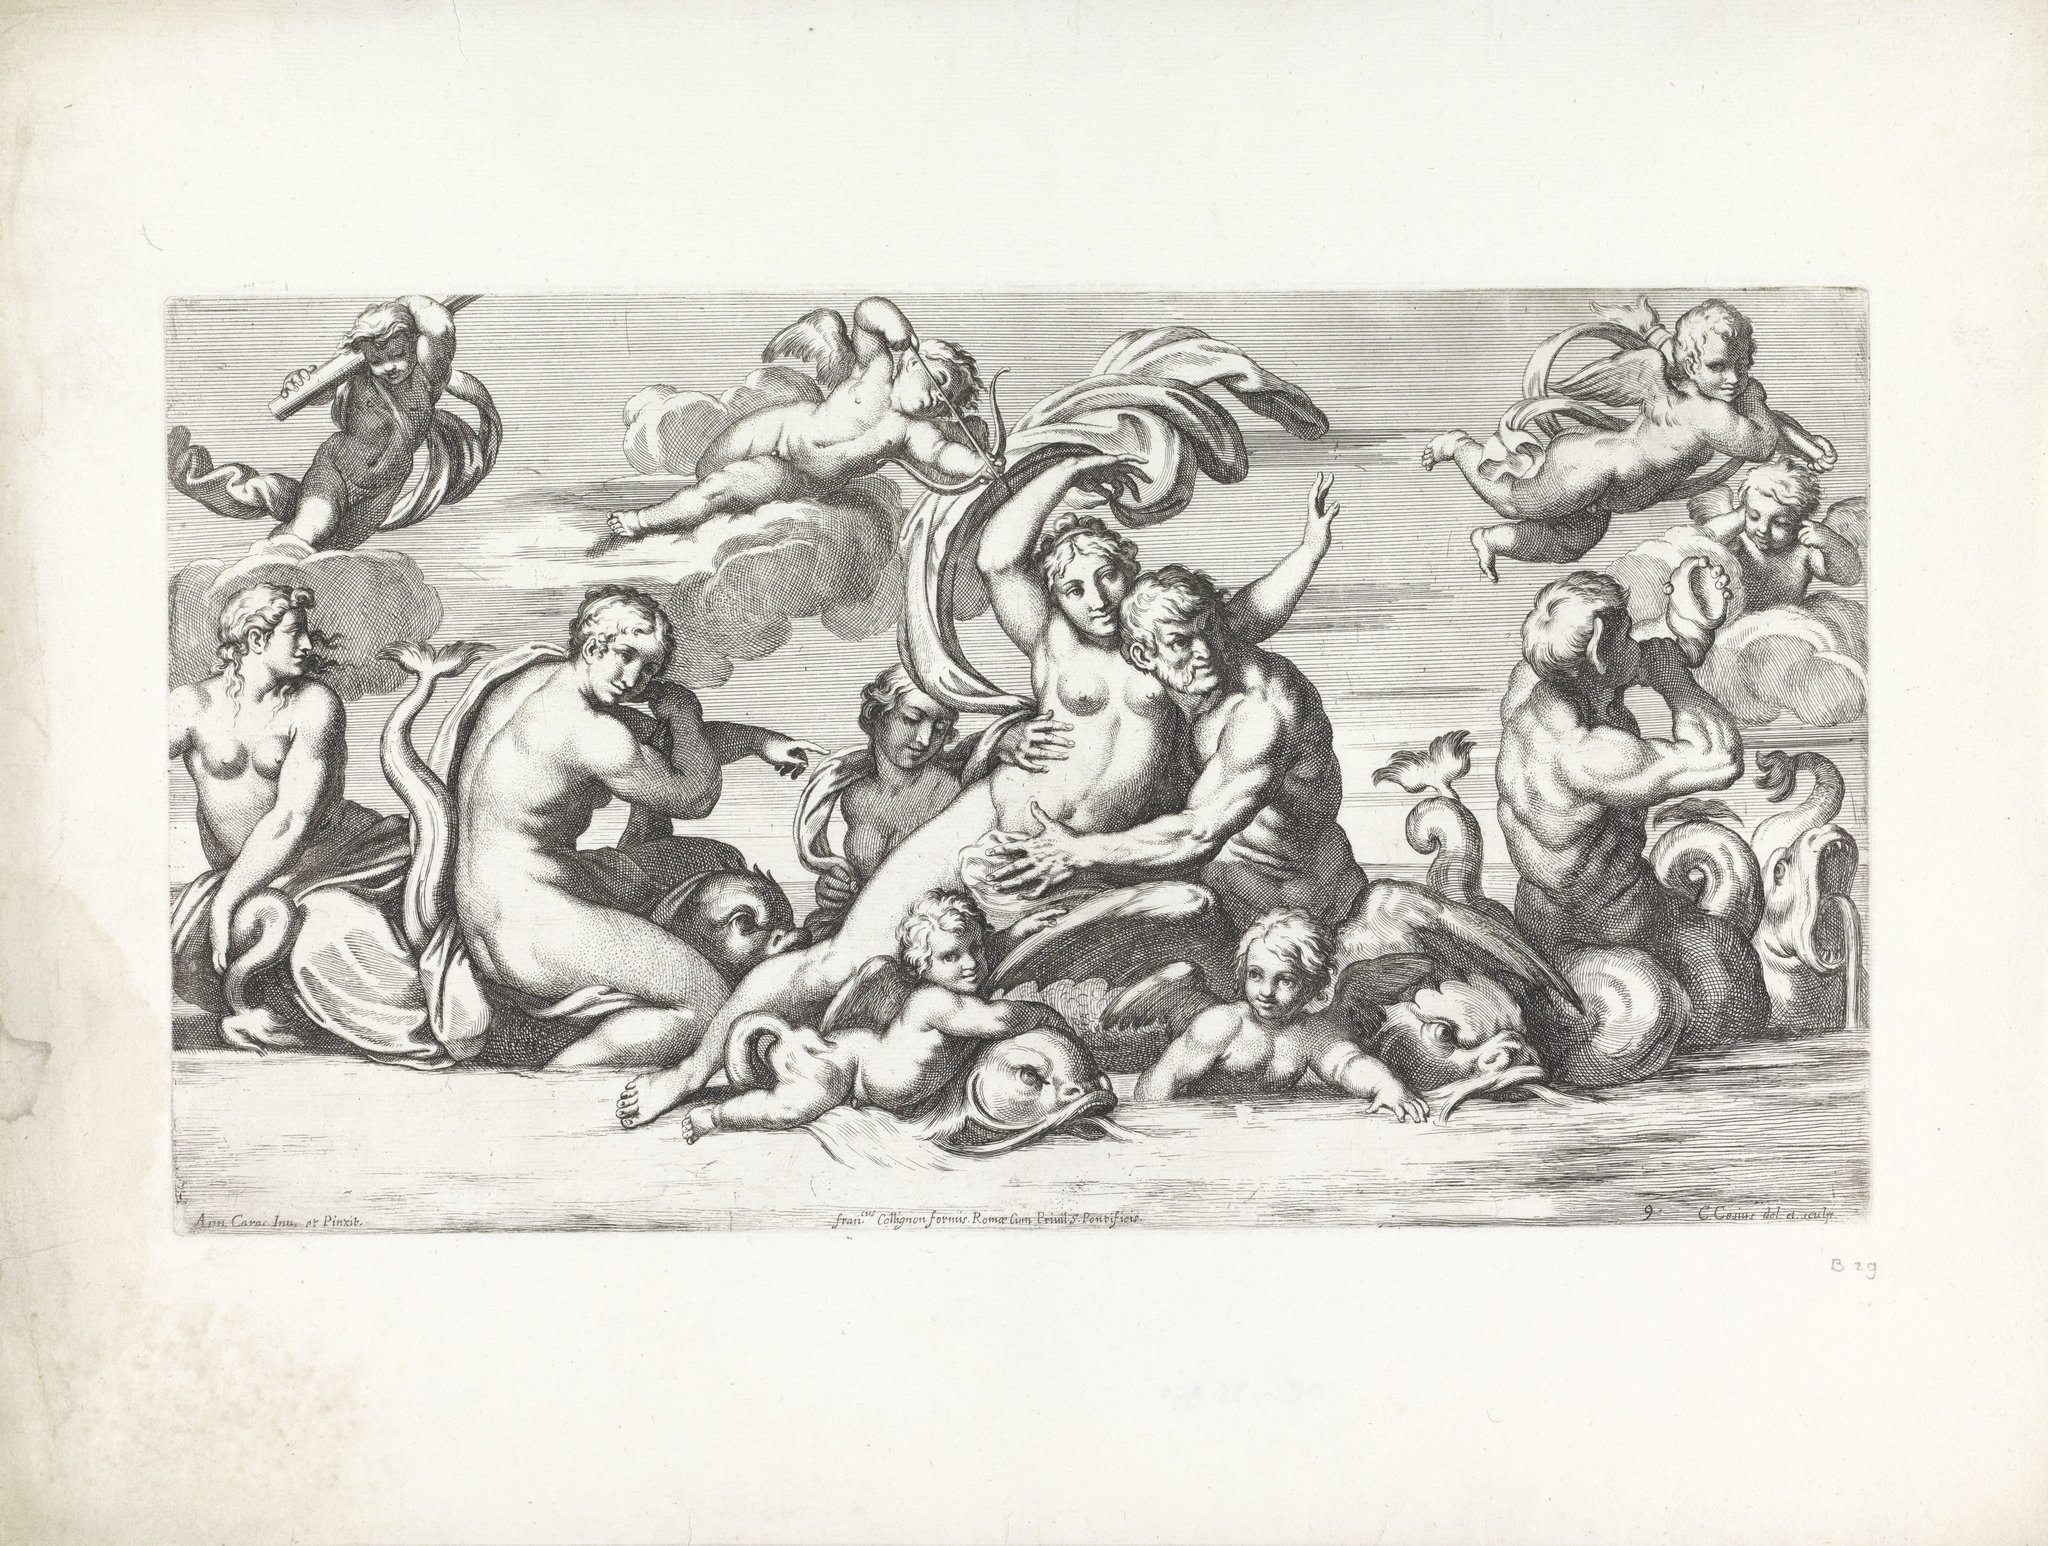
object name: print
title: Galeria nel Palazzo Farnese in Roma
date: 1656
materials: paper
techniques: etching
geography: vatican city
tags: triton(s), swimming mammals: dolphin, triumph of galatea, polyphemus playing the syrinx, other nereids (or sea-nymphs), cupids: 'amores', 'amoretti', 'putti'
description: Prent uit een reeks prenten met nummers van 1 tot en met 29 (sommige prenten hebben hetzelfde nummer), plus titelprent en opdracht, naar schilderingen in Palazzo Farnese te Rome.